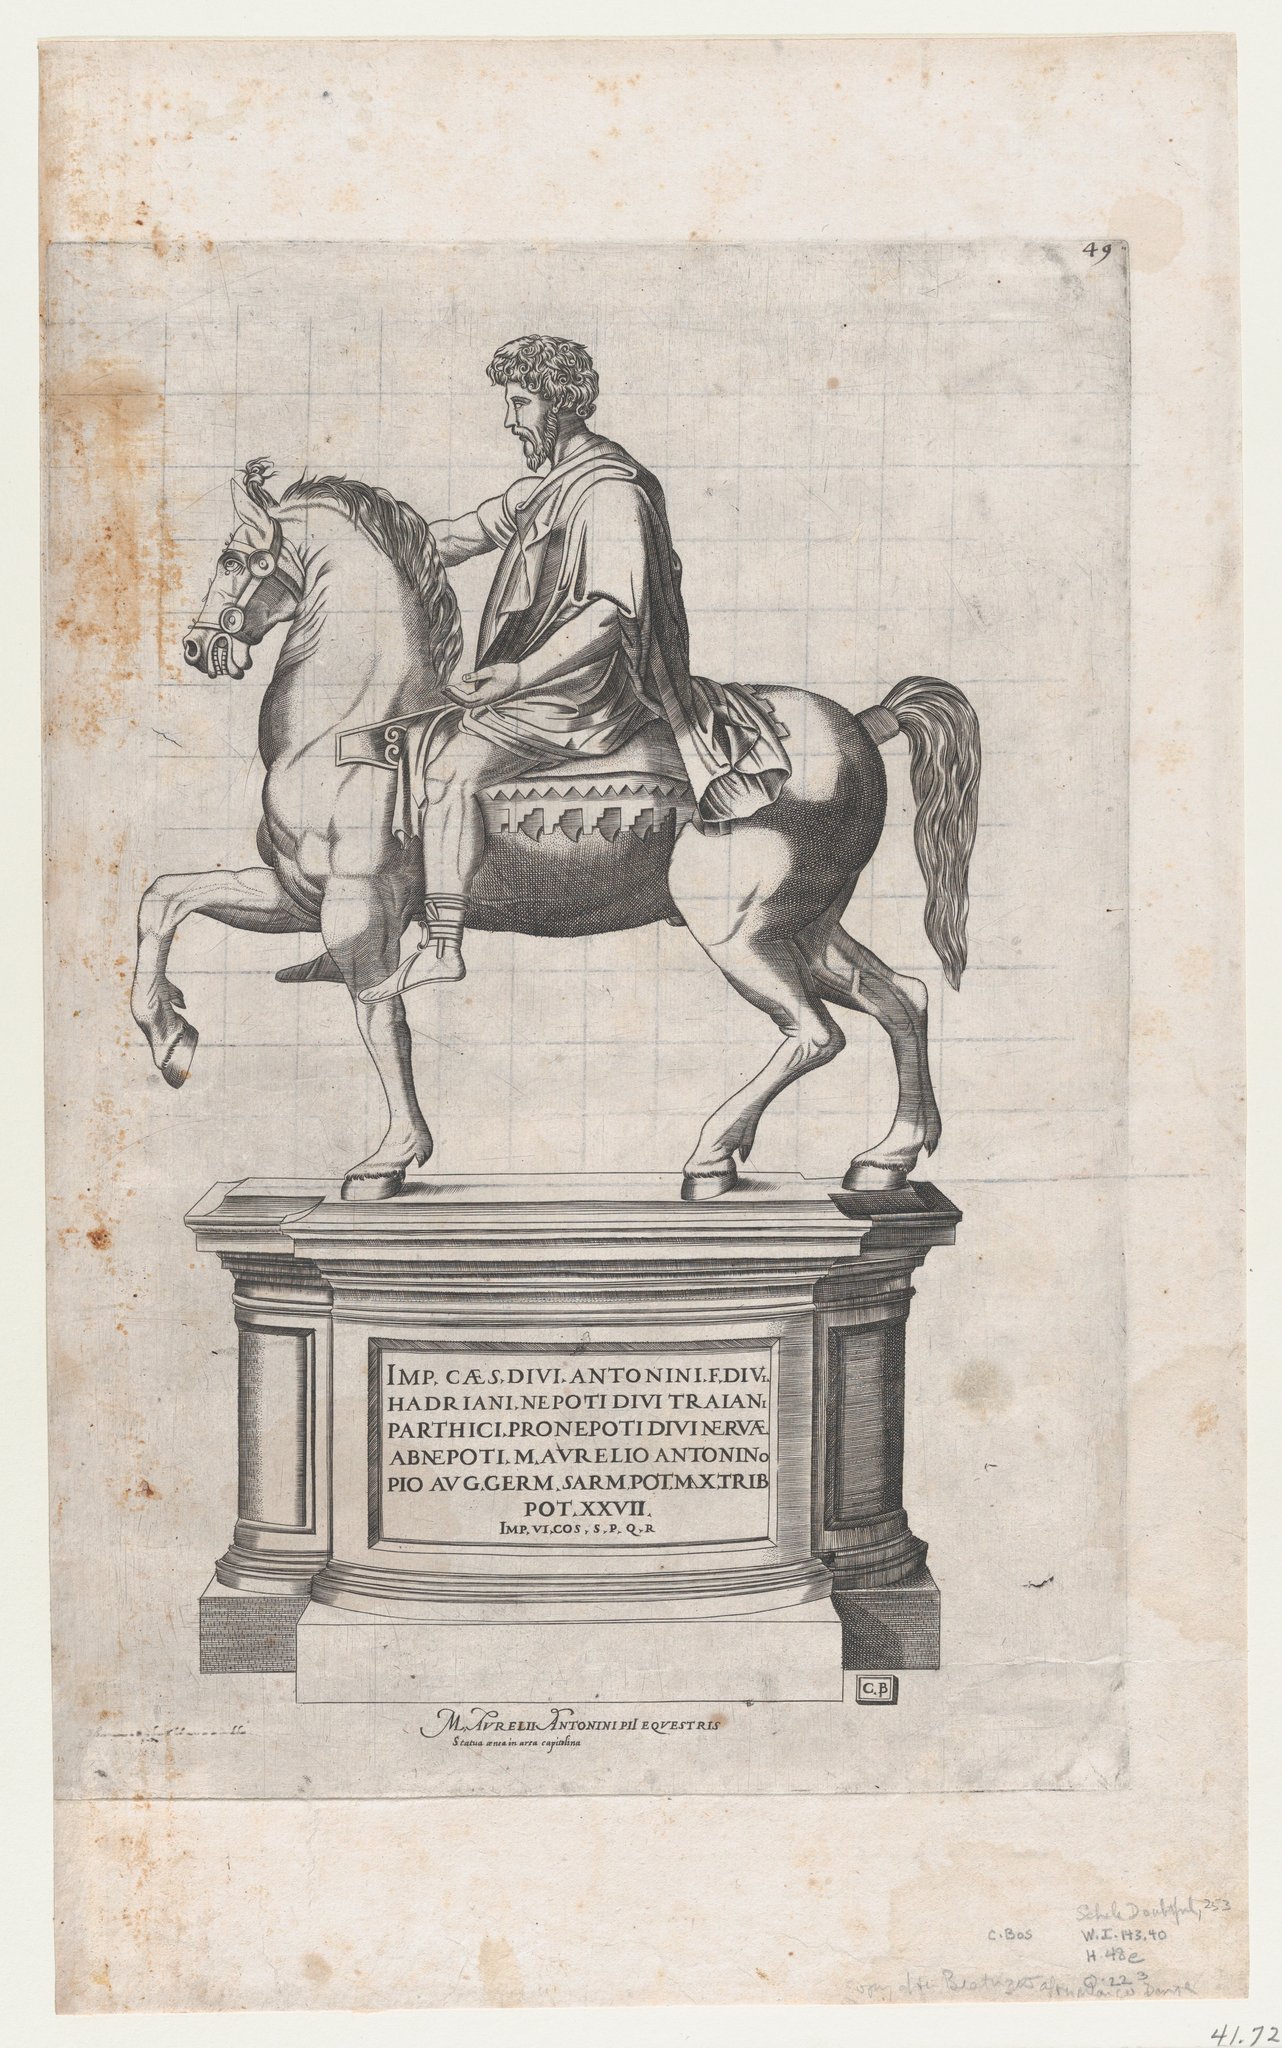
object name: print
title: Marcus Aurelius, from "Speculum Romanae Magnificentiae"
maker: cornelis bos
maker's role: artist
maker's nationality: netherlandish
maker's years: 1510-1556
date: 1501-1600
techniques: engraving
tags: men,horses